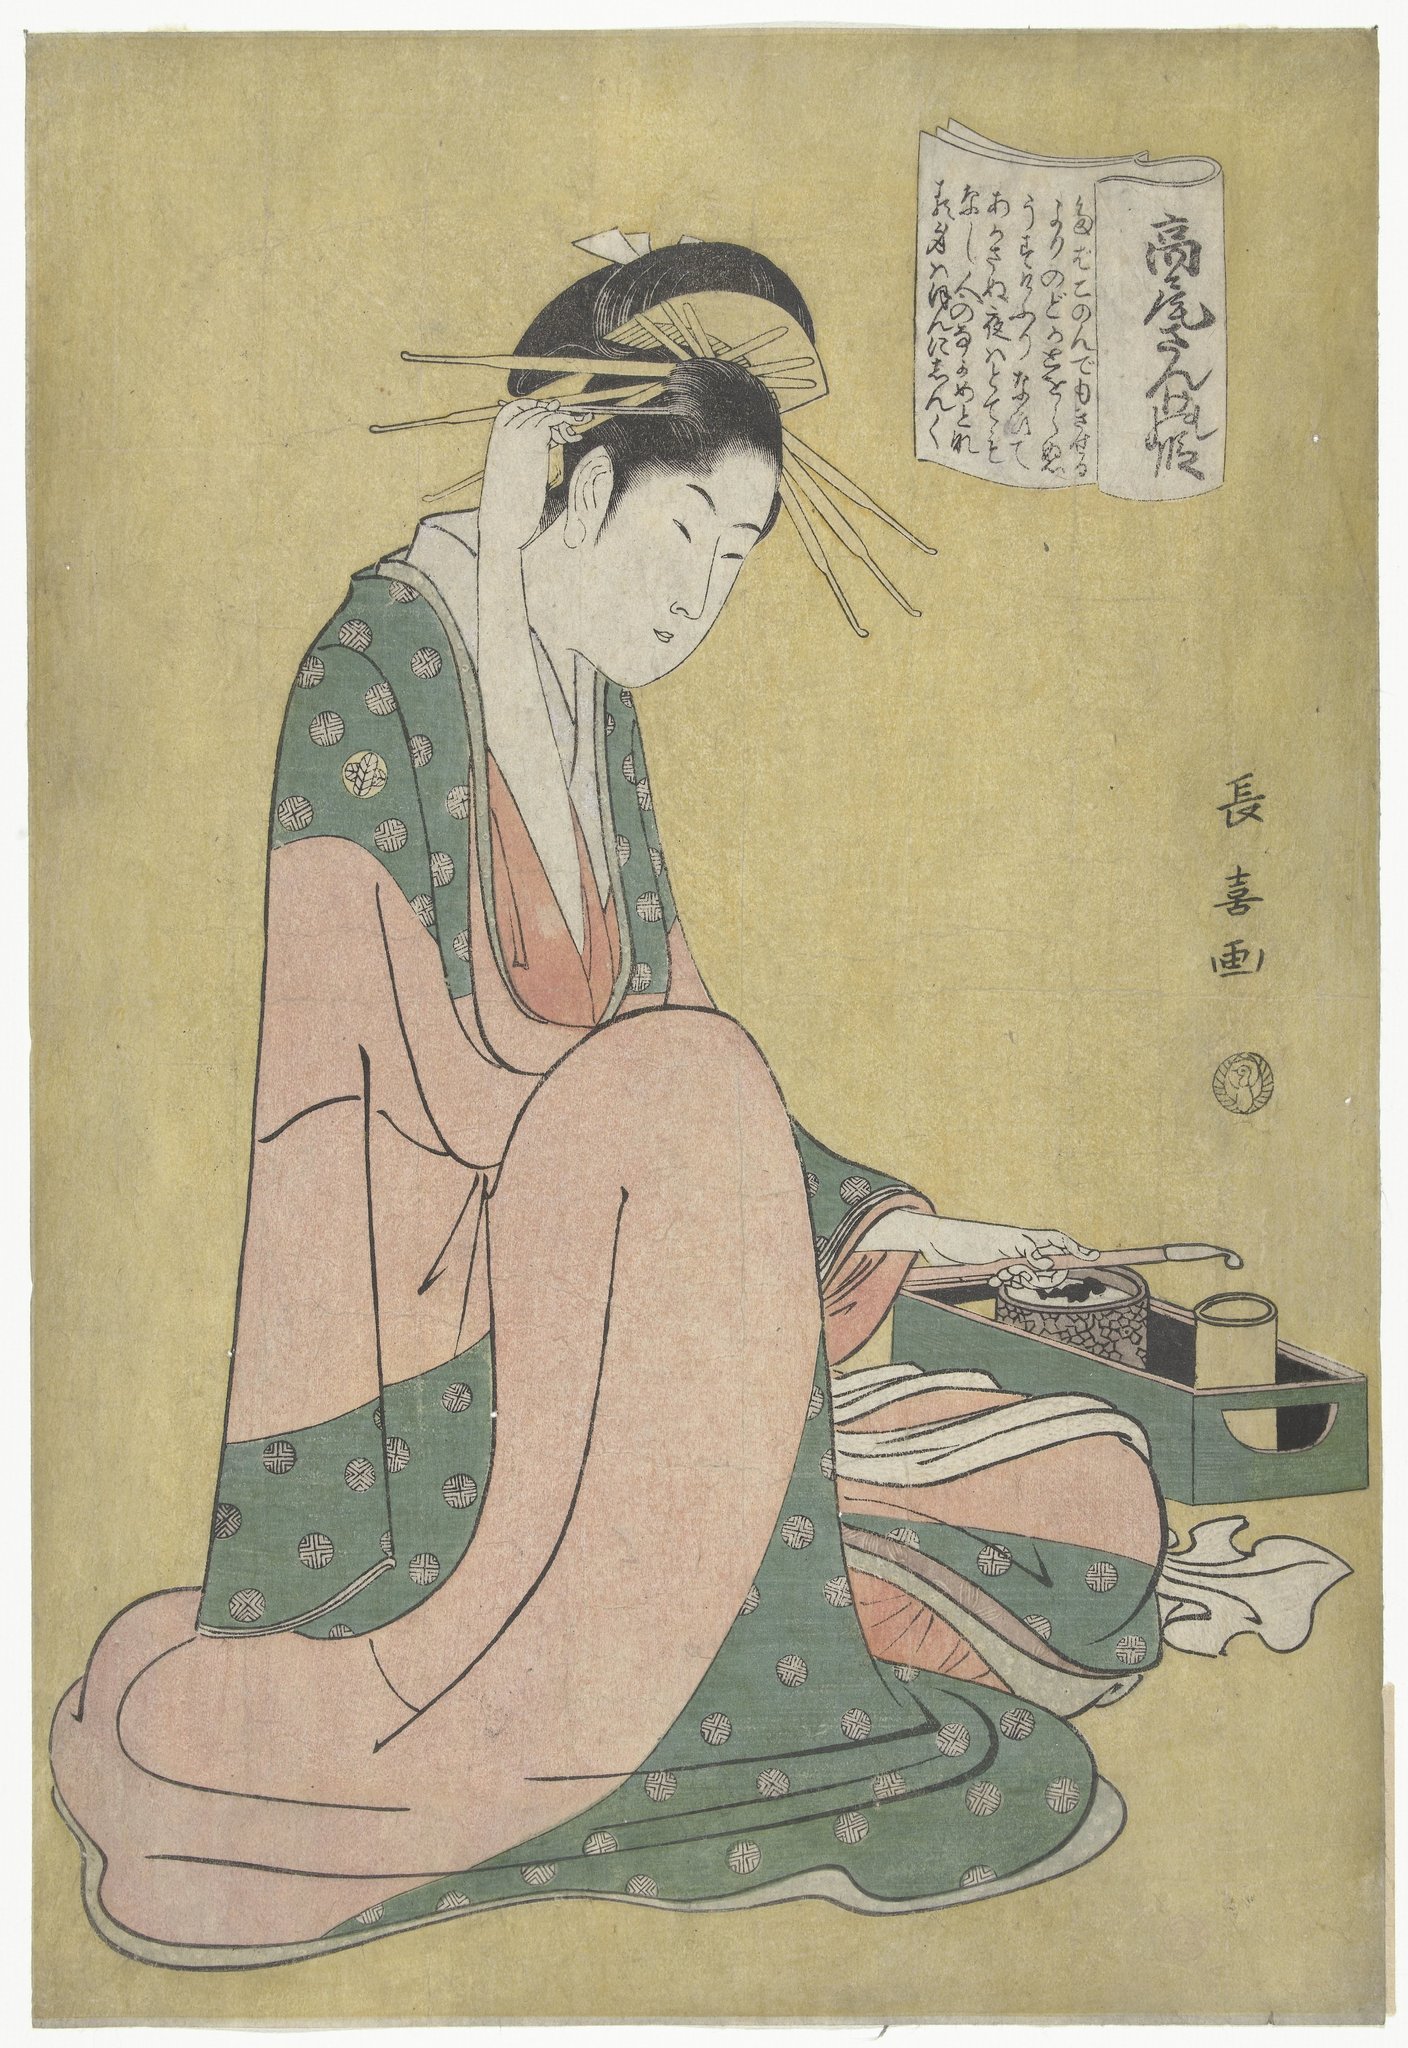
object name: print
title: Takao sange no dan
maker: eishôsai chôki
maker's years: 1785-1805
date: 1795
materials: paper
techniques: woodcut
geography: tokyo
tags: pipe ~ tobacco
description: Zittende courtisane, de rechter hand bij een haarpin en met de linker hand een pijp leeg kloppend in een potje van een rookset.